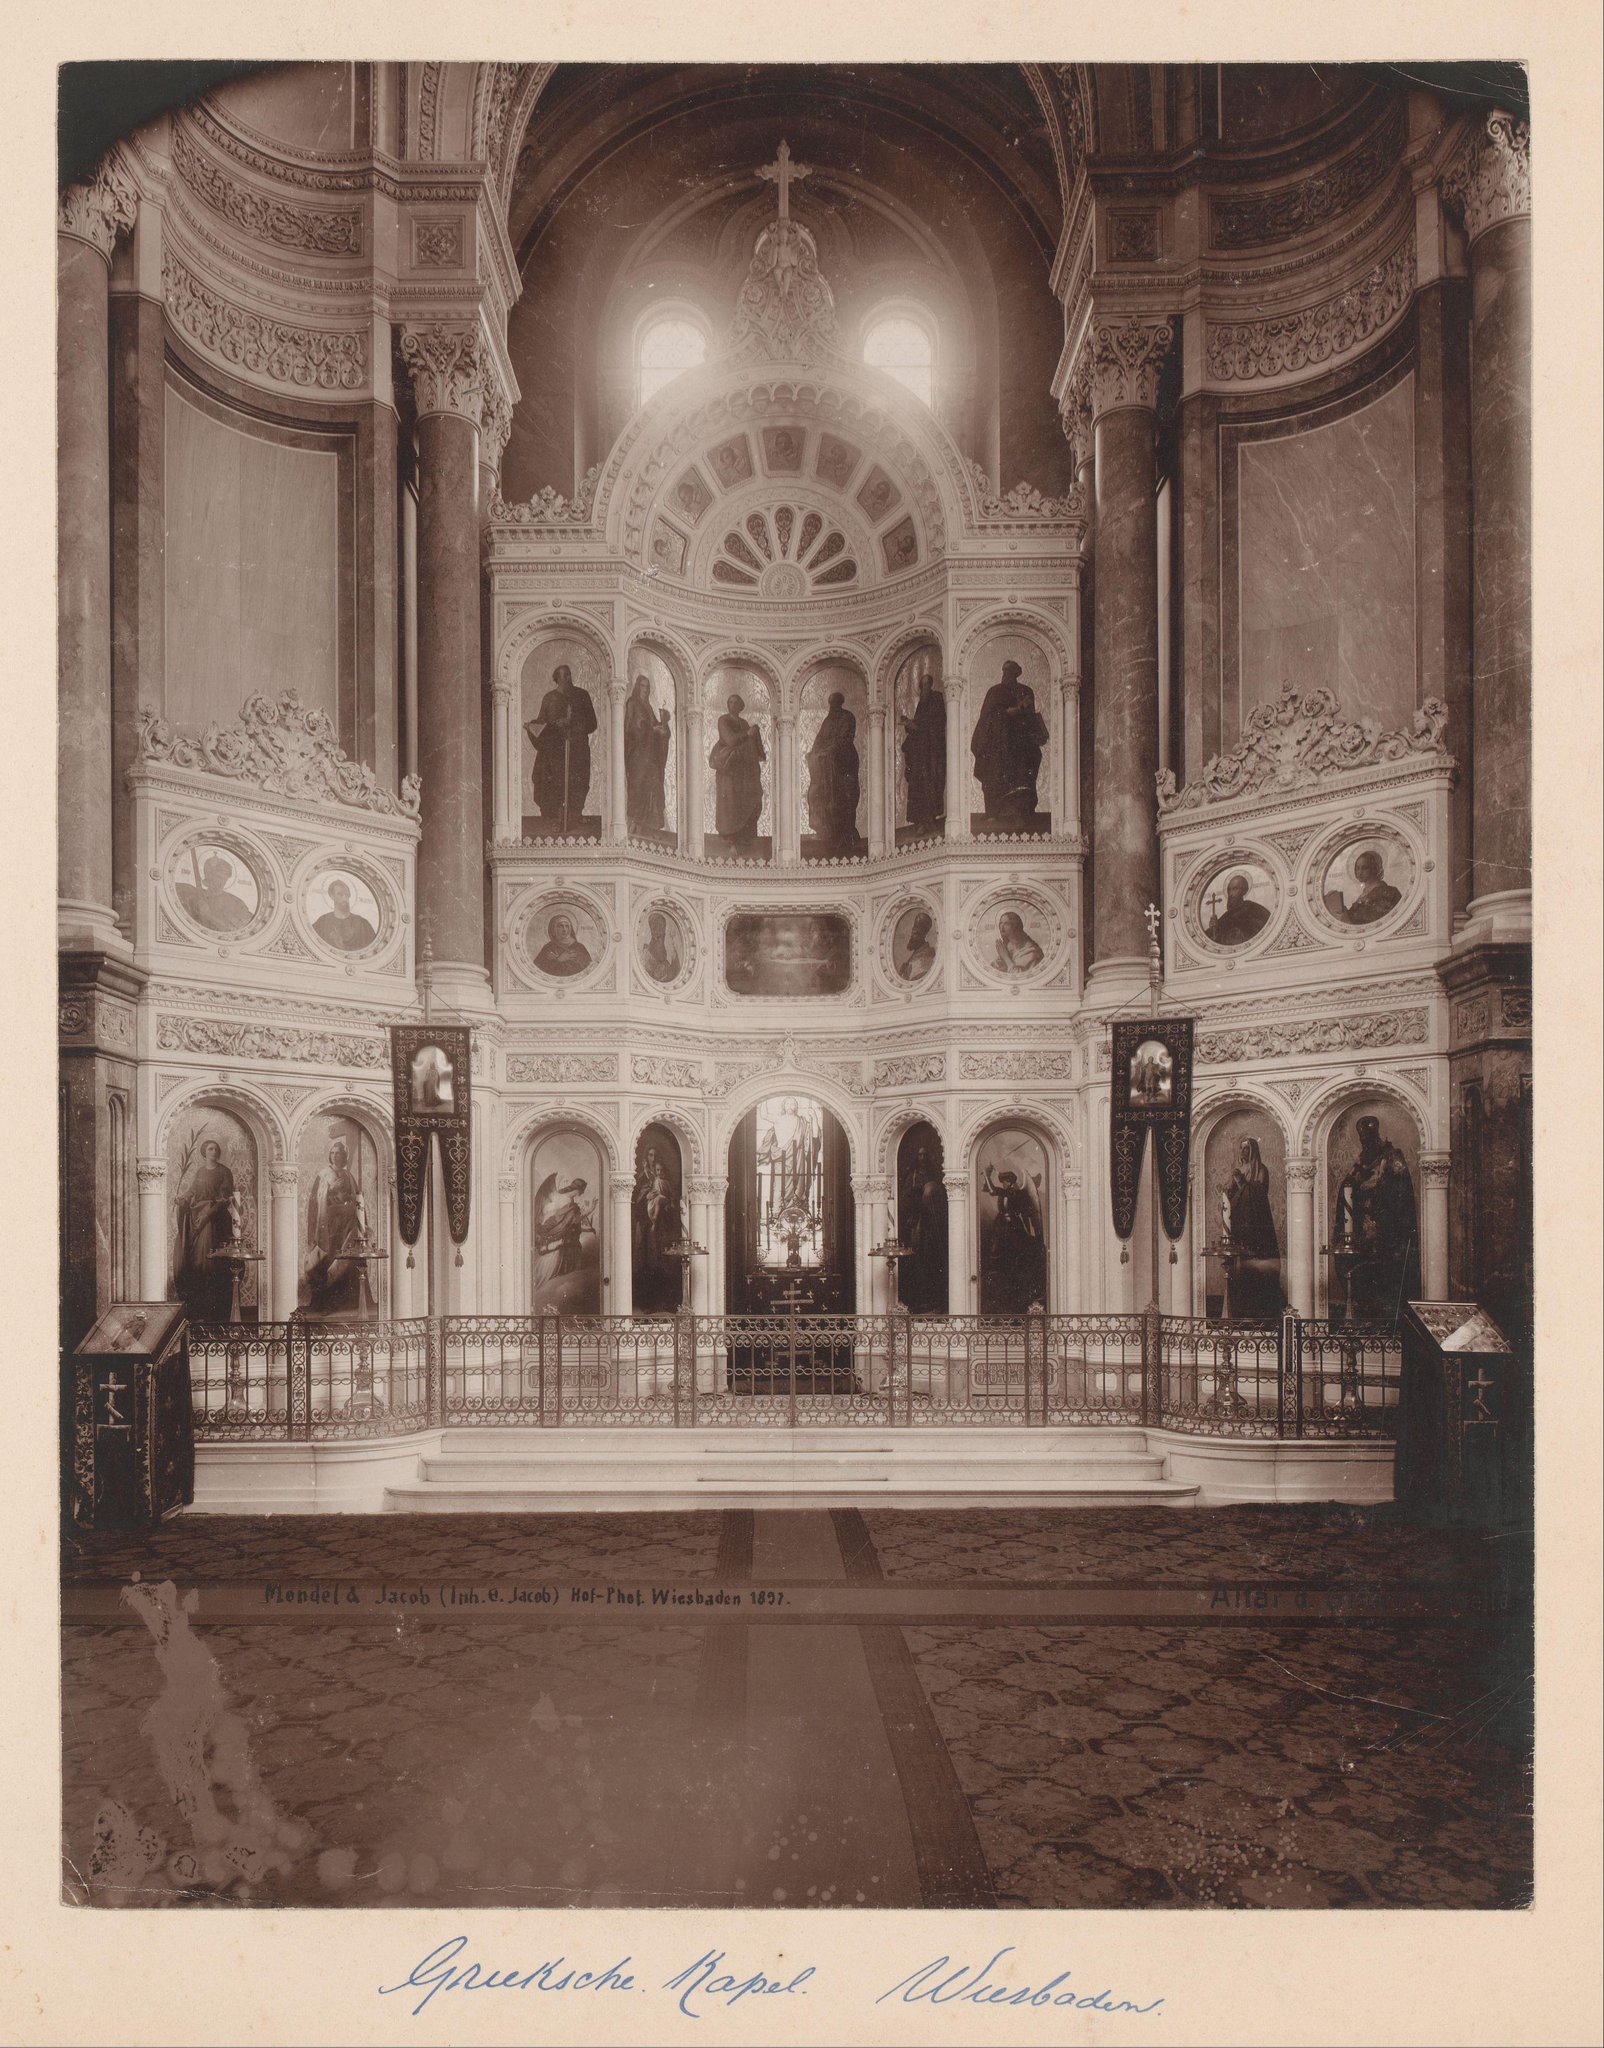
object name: photograph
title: Altaar van de zogenaamde Griekse Kapel in de Russisch-orthodoxe Kerk op de Neroberg, Wiesbaden, Duitsland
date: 1897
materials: cardboard, paper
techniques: albumen print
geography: wiesbaden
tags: wiesbaden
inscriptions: inscription: ‘Altar d. Griechischen Kapelle’, signature and date: ‘Mondel & Jacob (Inh. G. Jacob) Hof-Phot. Wiesbaden 1897.’, caption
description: Foutief 'Griekse Kapel' genoemde deel in de Russisch-orthodoxe kerk "der heiligen Elisabeth in Wiesbaden", die Adolf von Nassau als graf voor zijn jong overleden vrouw Elisabeta Michailovna (dochter van de jongere broer van de tsaren Alexander I en Nicolaas I van Rusland) tussen 1847-1855 liet bouwen.